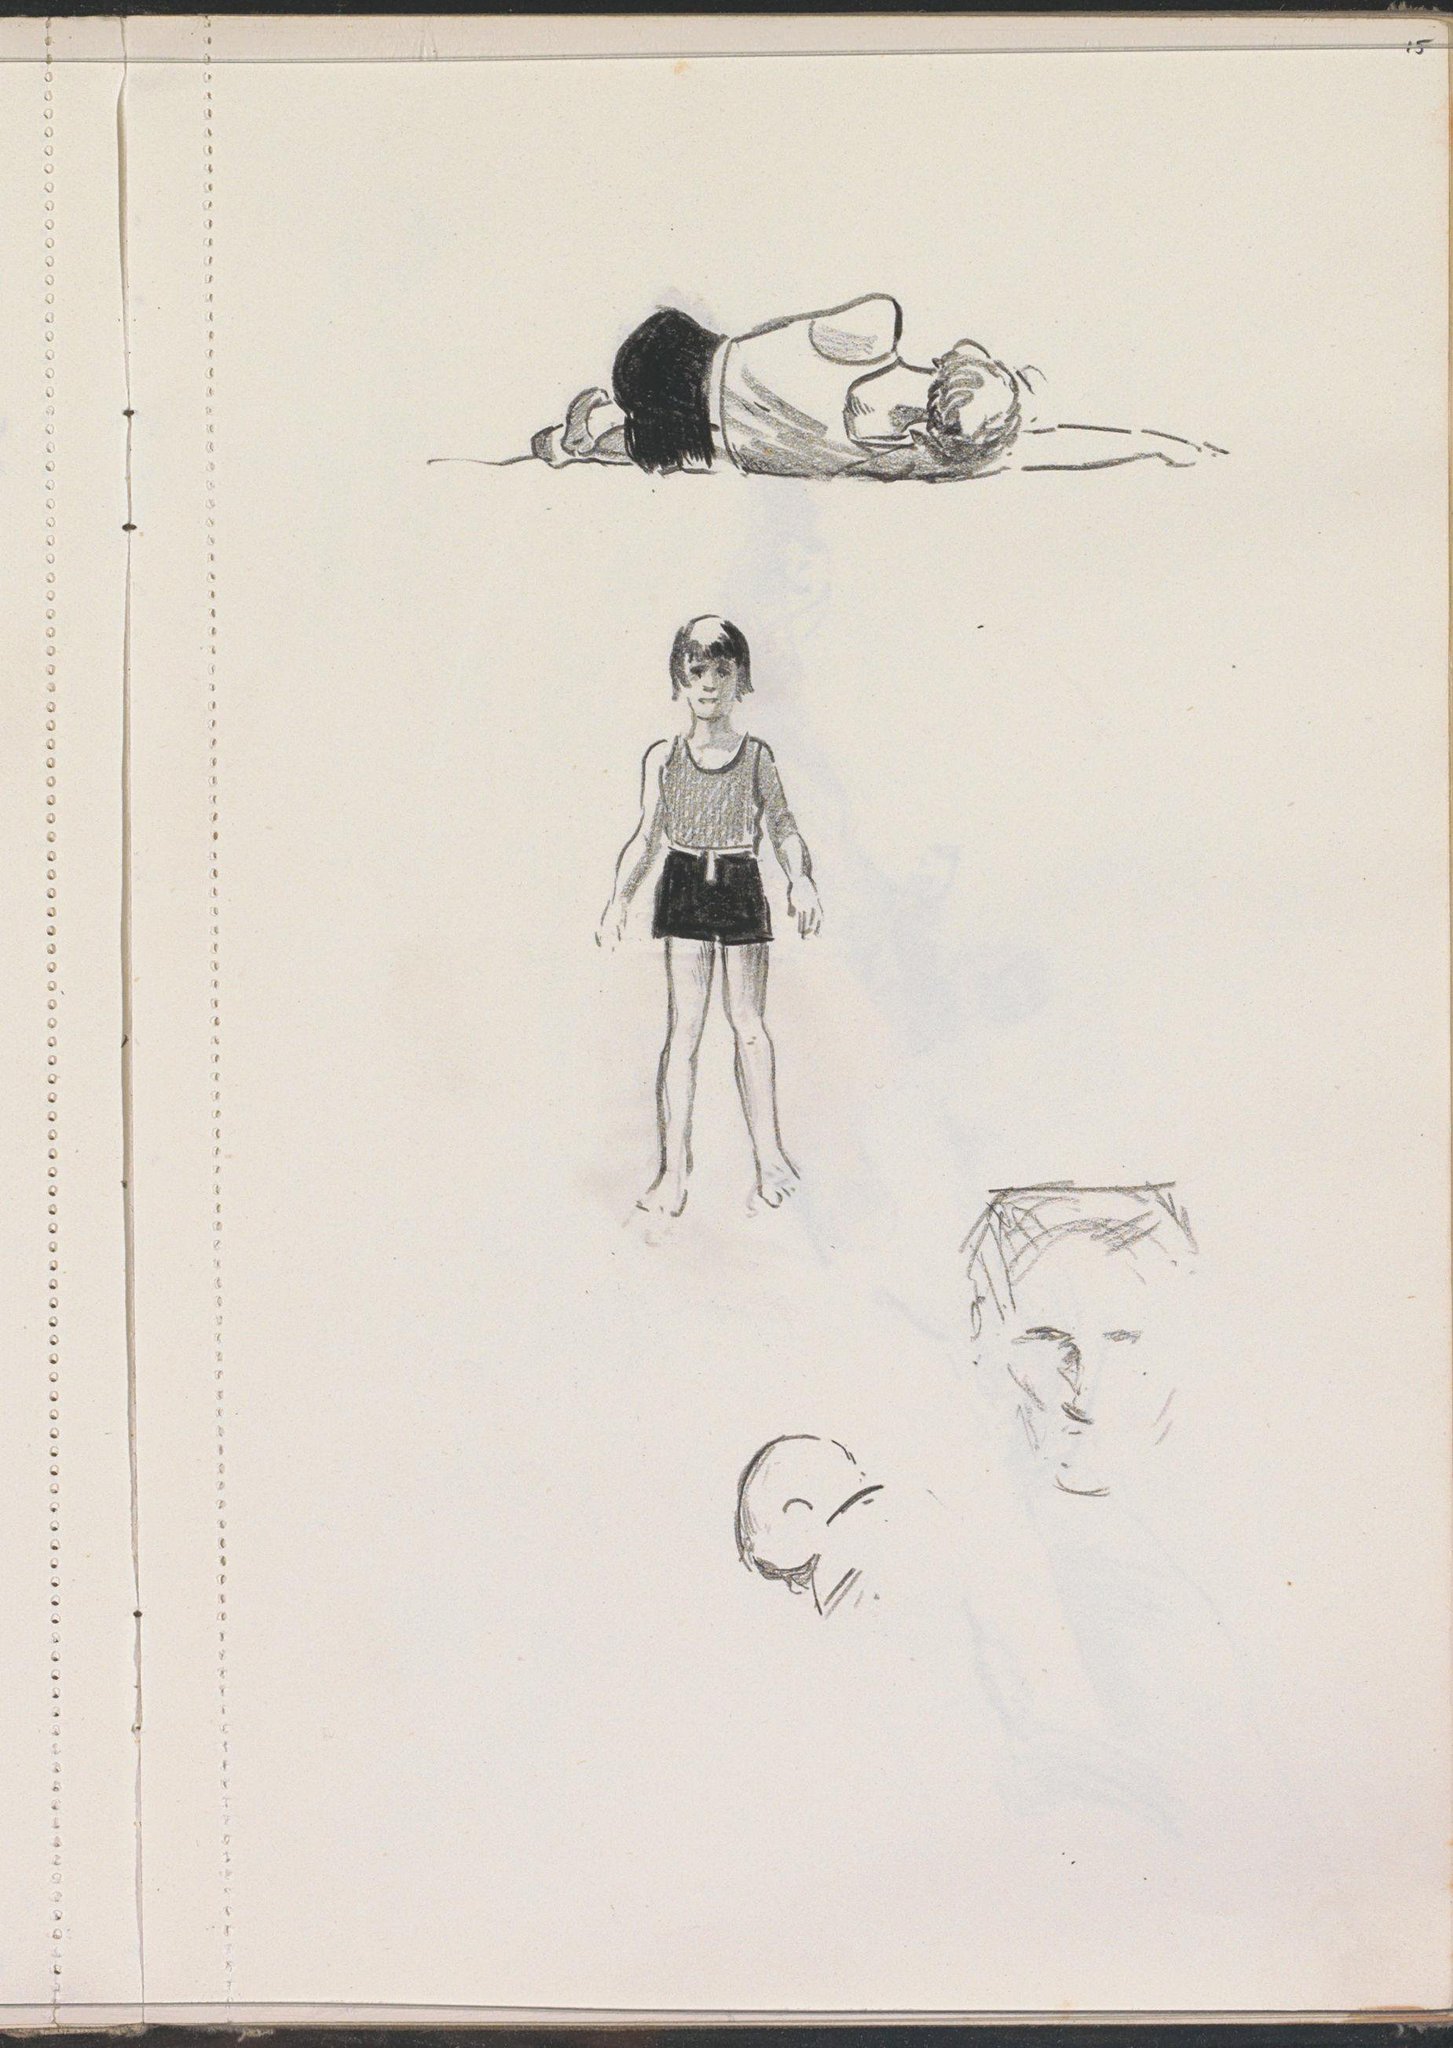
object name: sketchbook leaf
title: Liggende figuur en een kind in zwemkleding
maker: otto verhagen (i)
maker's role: draughtsman, print maker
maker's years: 1885-1951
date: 1930-1940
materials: chalk, paper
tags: head (human), child, lying figure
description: Tevens een studie van een hoofd. Pagina 15 uit een schetsboek met 60 bladen.